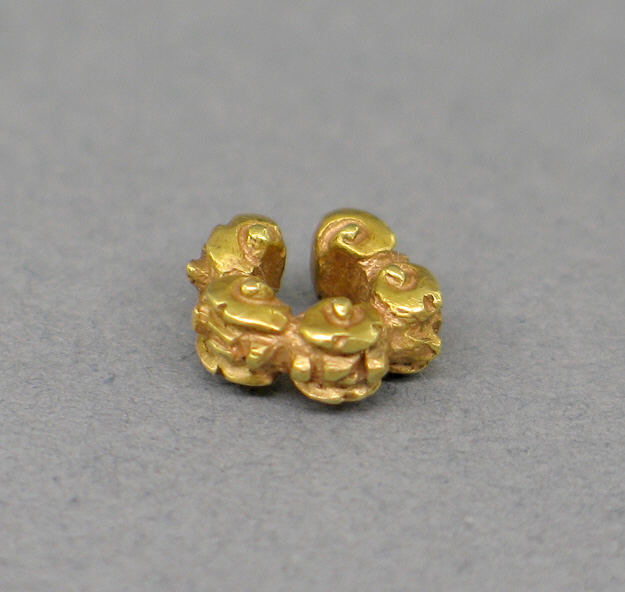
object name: ear clip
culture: indonesian, javanese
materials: gold